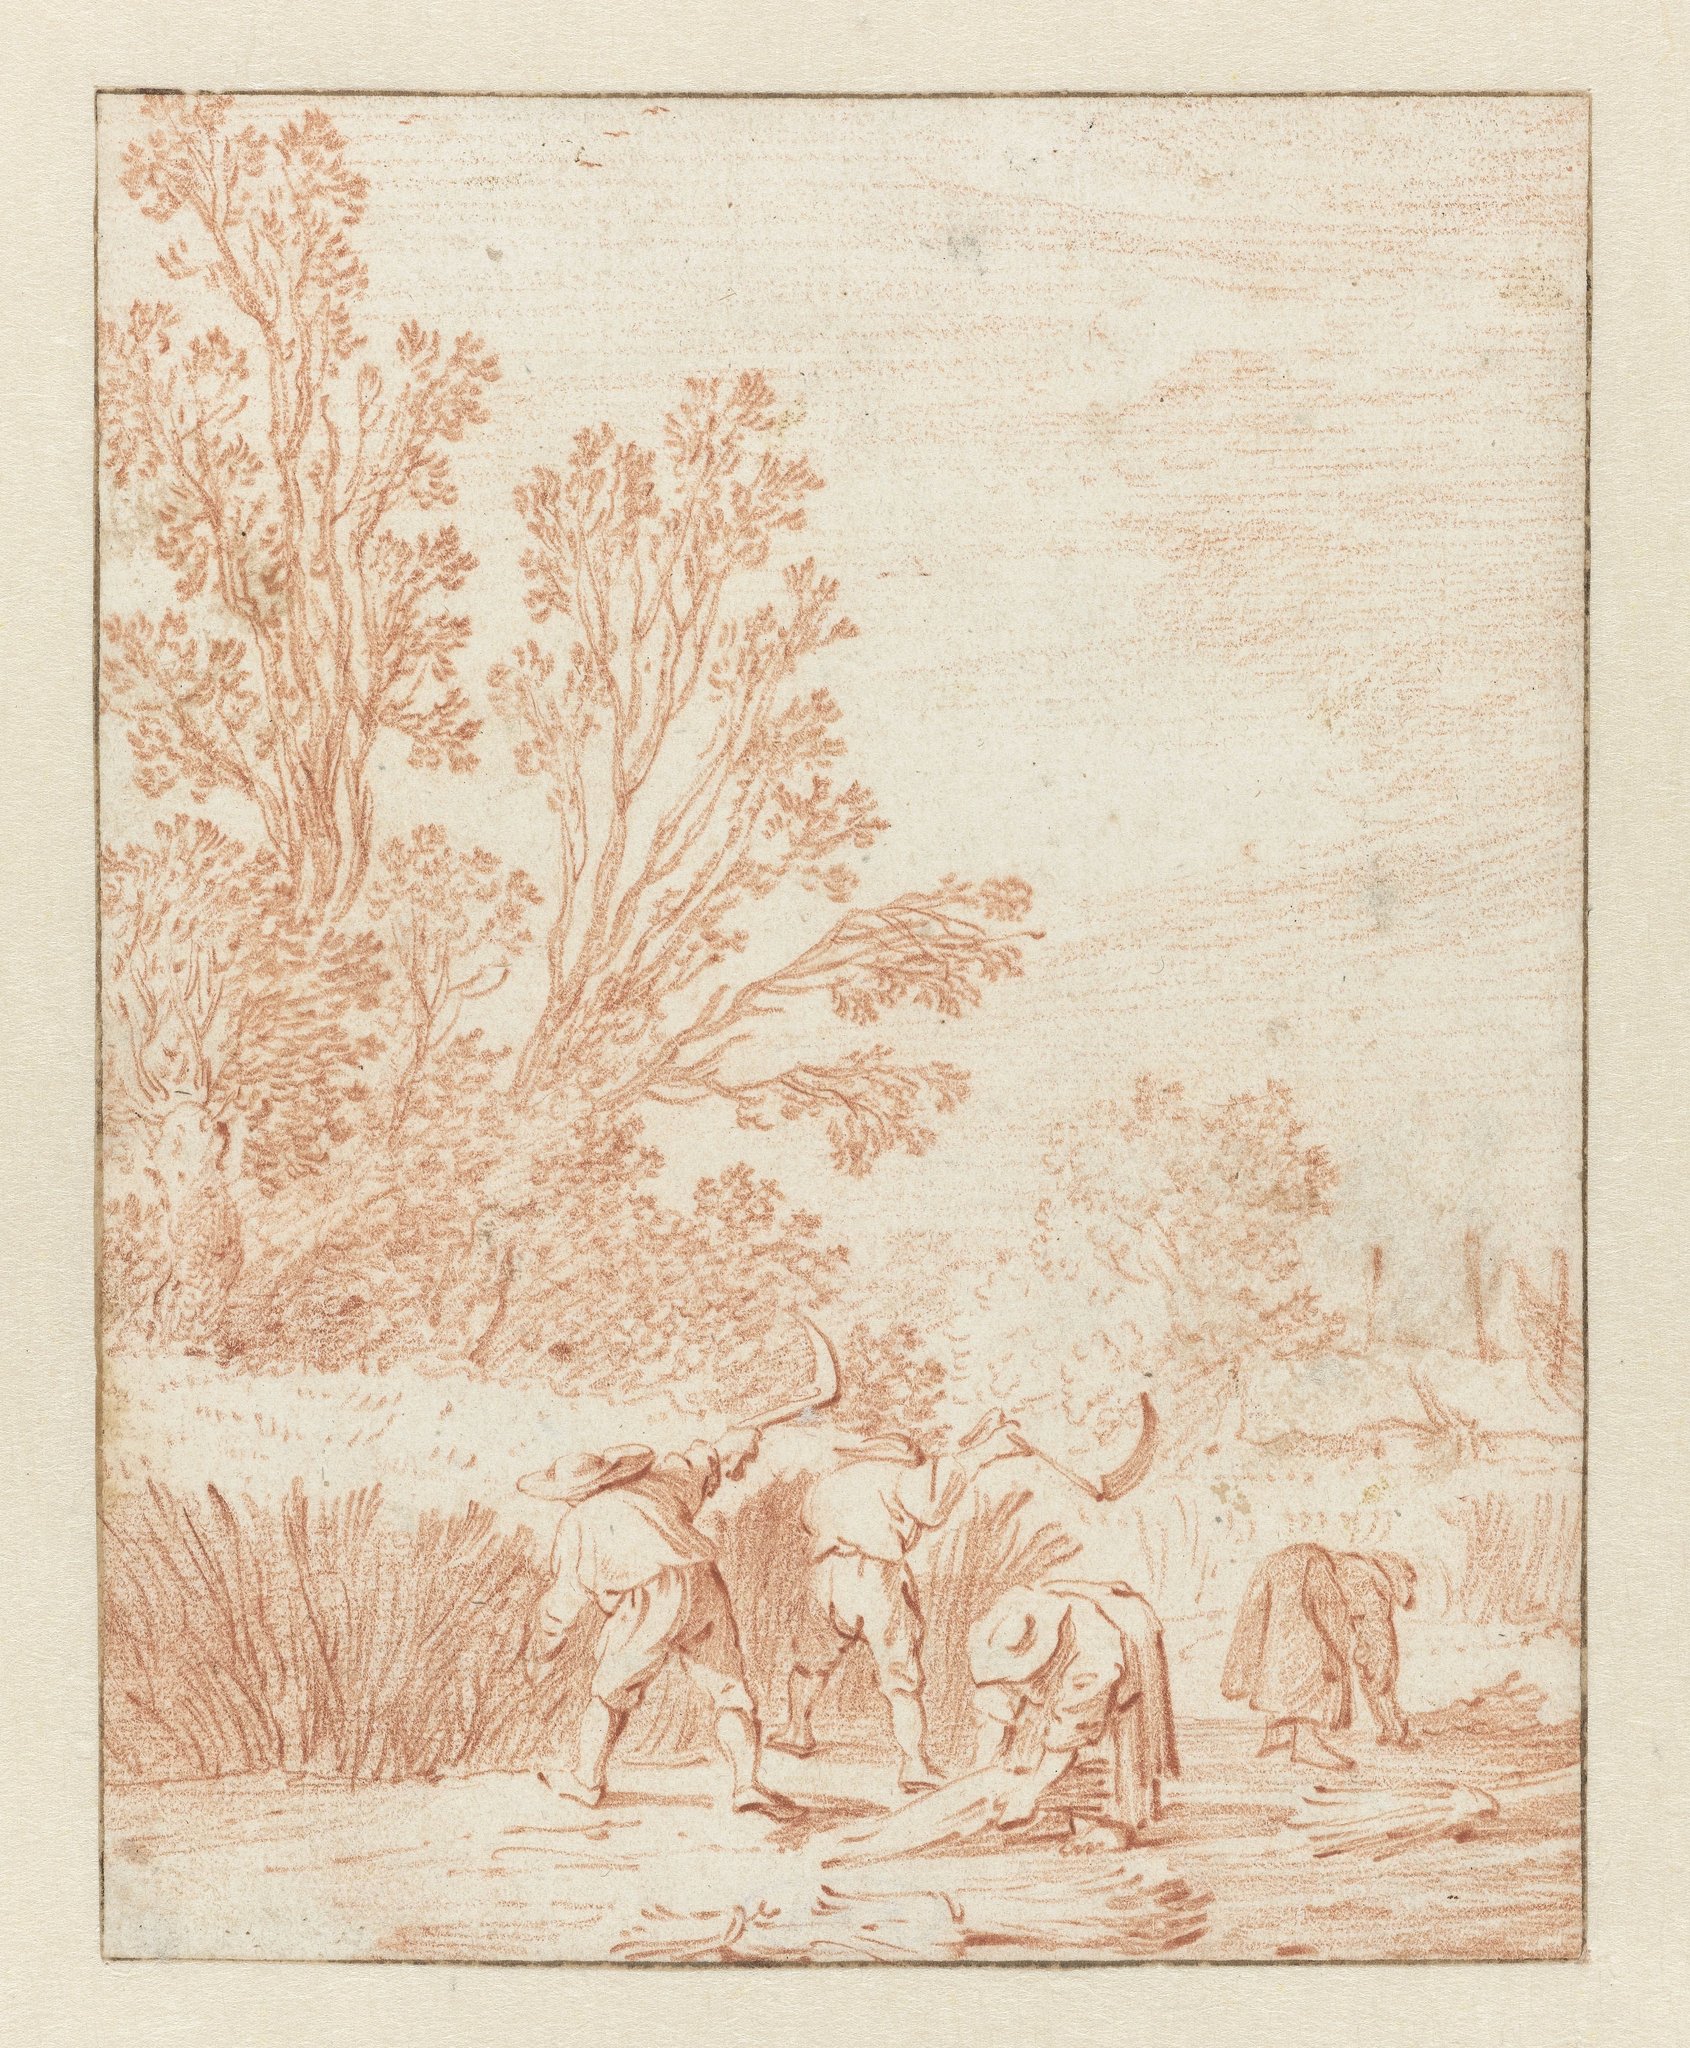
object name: drawing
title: Augustus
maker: Anonymous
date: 1629-1680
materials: chalk, paper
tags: august and its 'labours', binding ~ harvest, reaping, picking, mowing ~ harvest